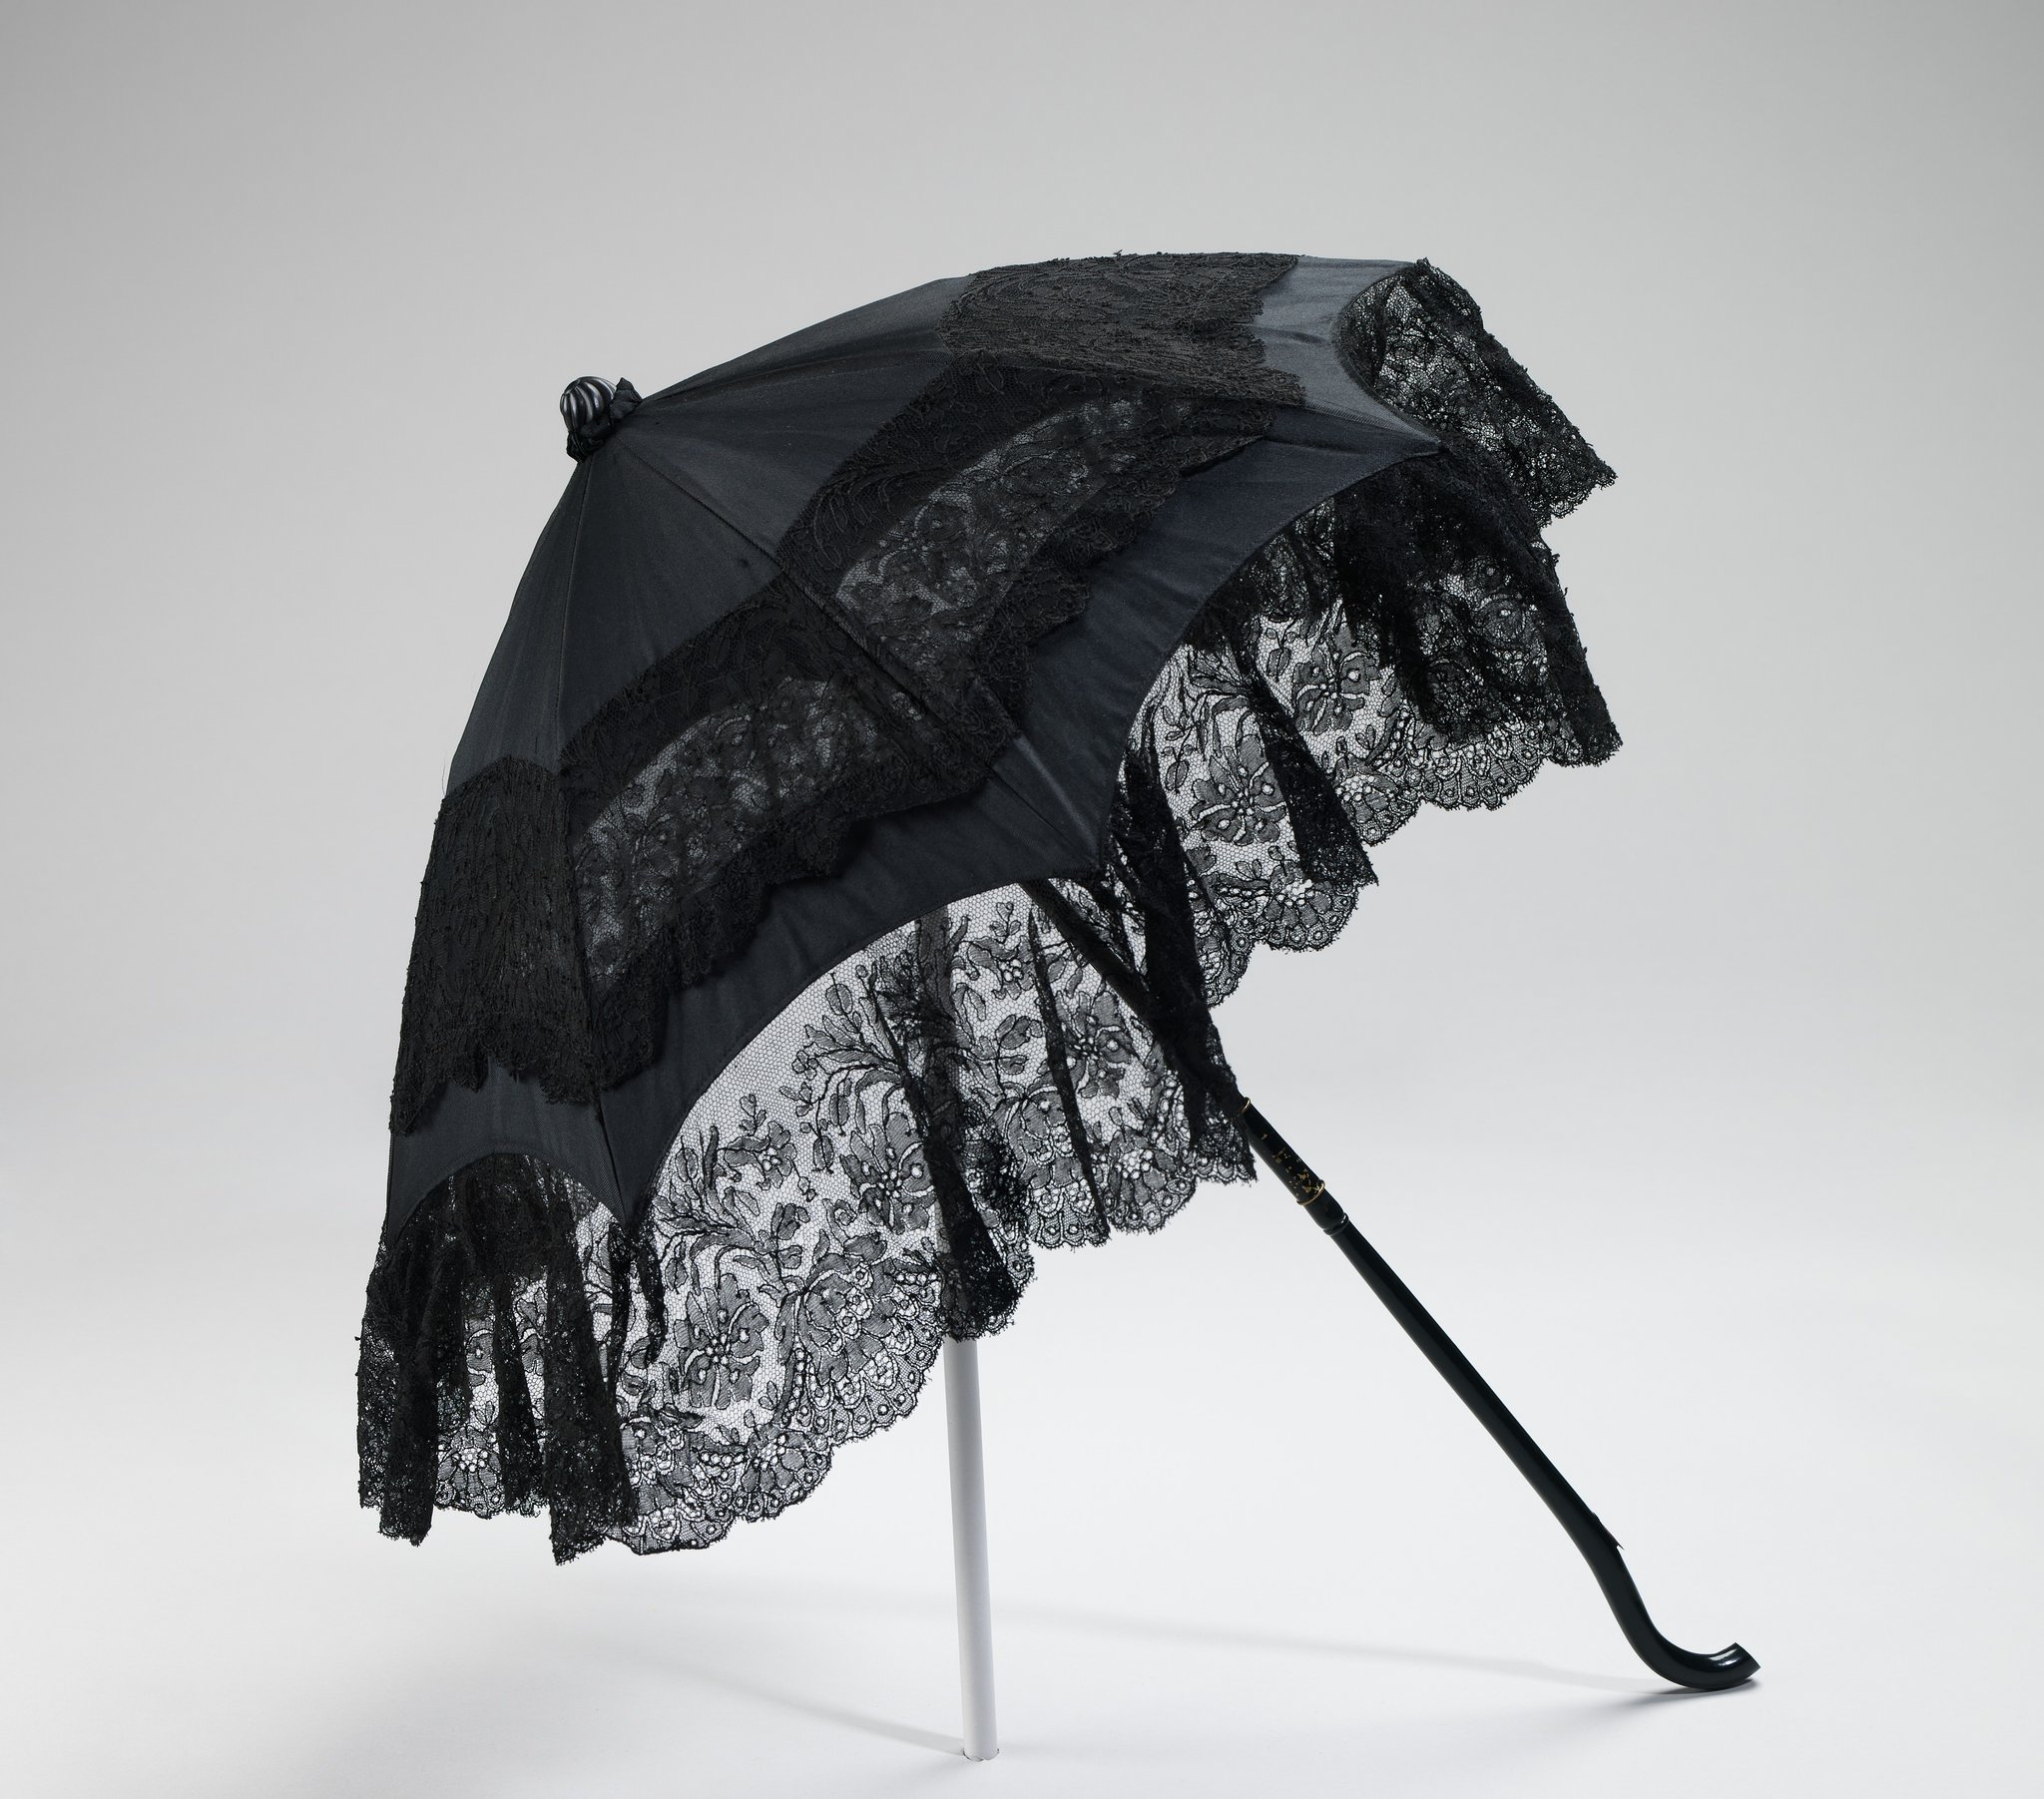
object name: parasol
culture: american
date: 1845-1855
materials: metal, silk, wood